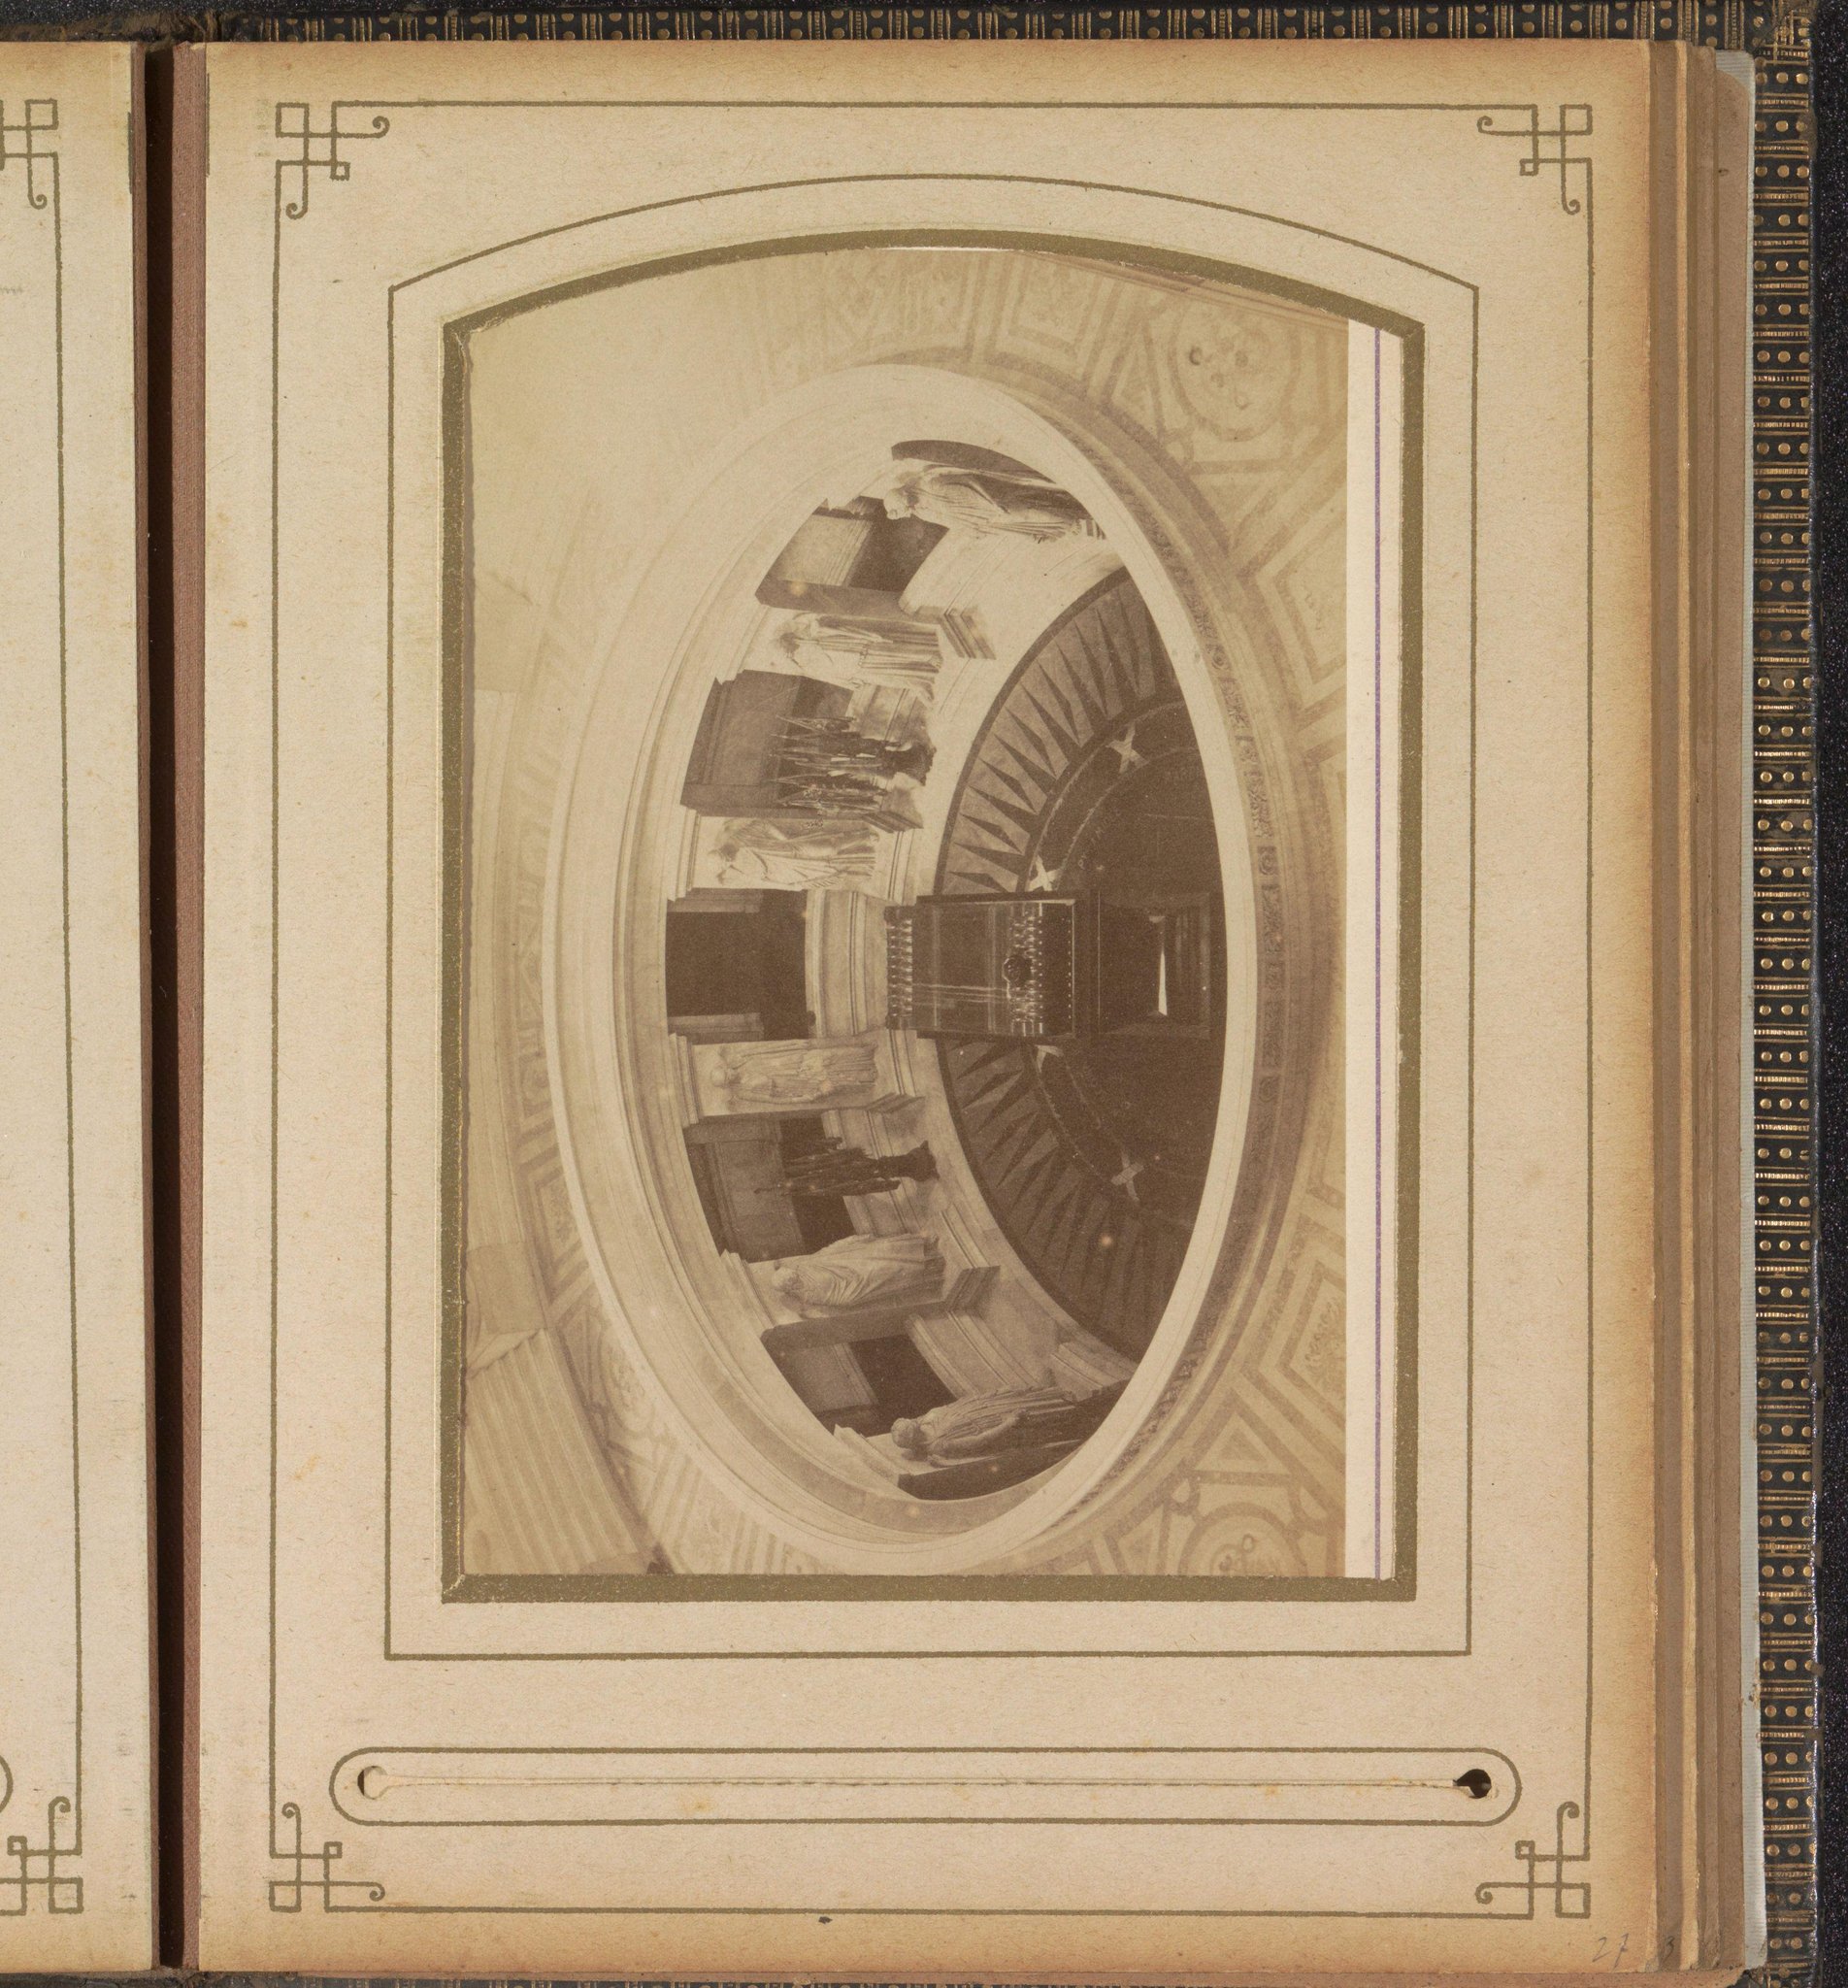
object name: photograph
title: Graftombe van Napoleon I in de Dôme des Invalides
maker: Anonymous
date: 1870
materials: cardboard, paper, photographic support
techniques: albumen print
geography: paris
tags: grave, tomb, paris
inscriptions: inscription: ‘tombeau Napoléon 1er Parijs’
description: Onderdeel van Fotoalbum met kabinetfoto's van bezienswaardigheden in Parijs.